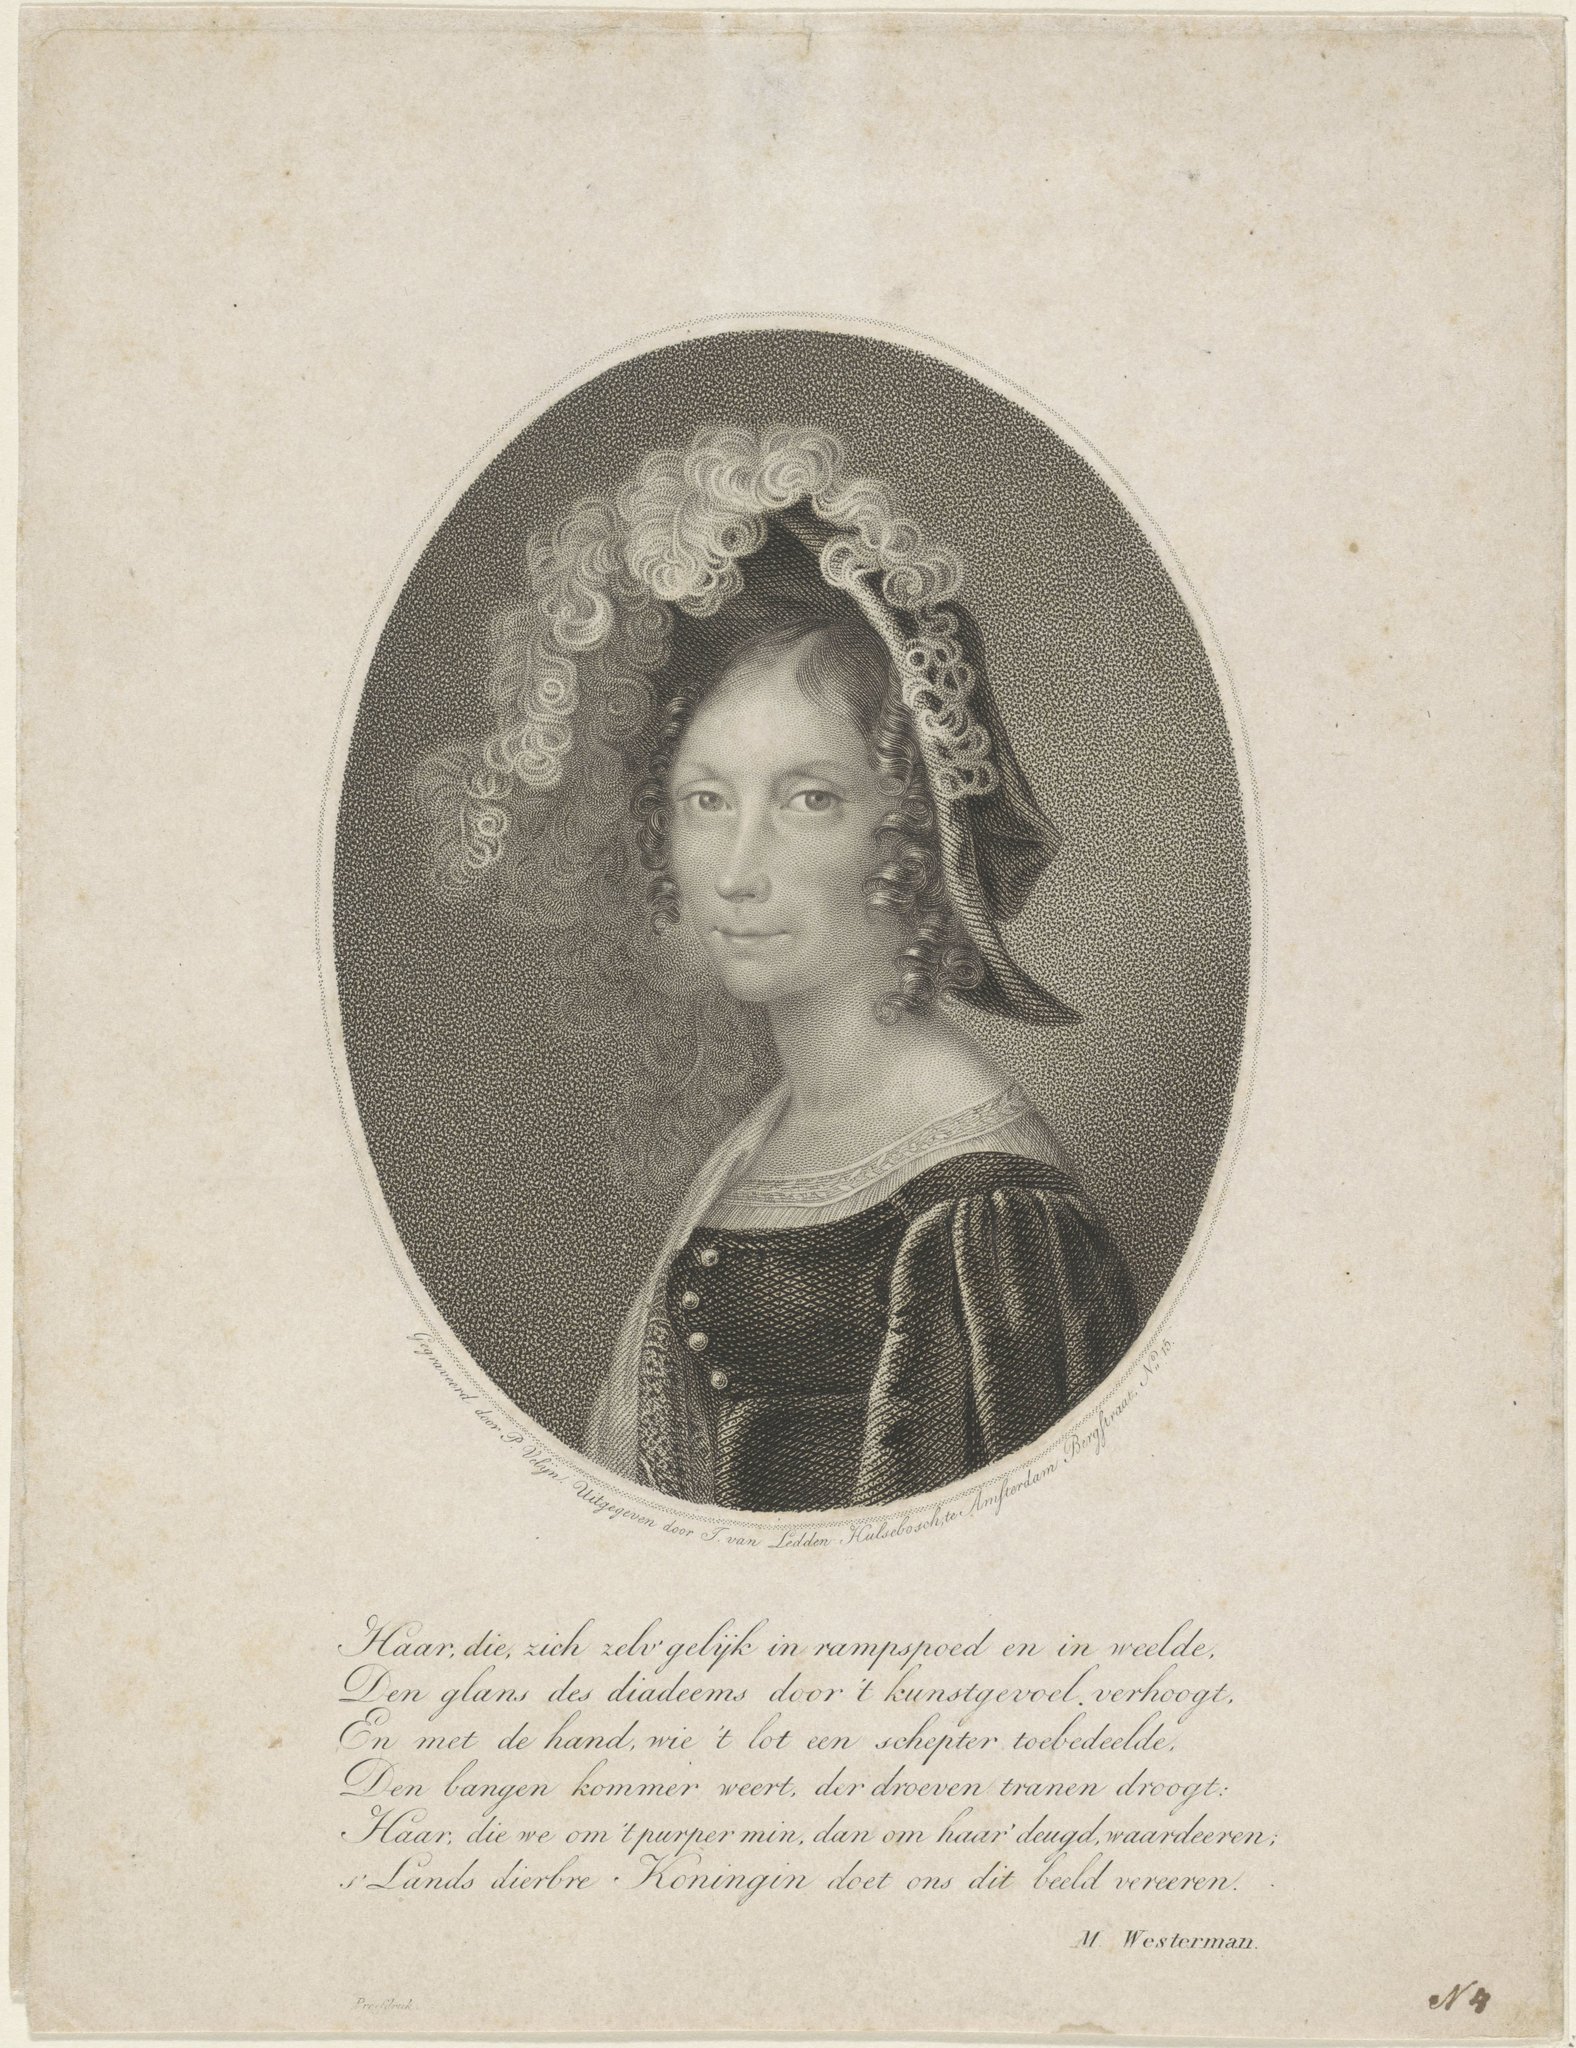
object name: print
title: Portret van Wilhelmina van Pruisen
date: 1813-1819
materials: paper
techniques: engraving, etching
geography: netherlands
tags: berlin, wilhelmina frederica louisa (koningin der nederlanden)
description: Portret van Wilhelmina in een ovaal. In de ondermarge zes regels Nederlandse tekst. Linksonder 'Proefdruk.'.